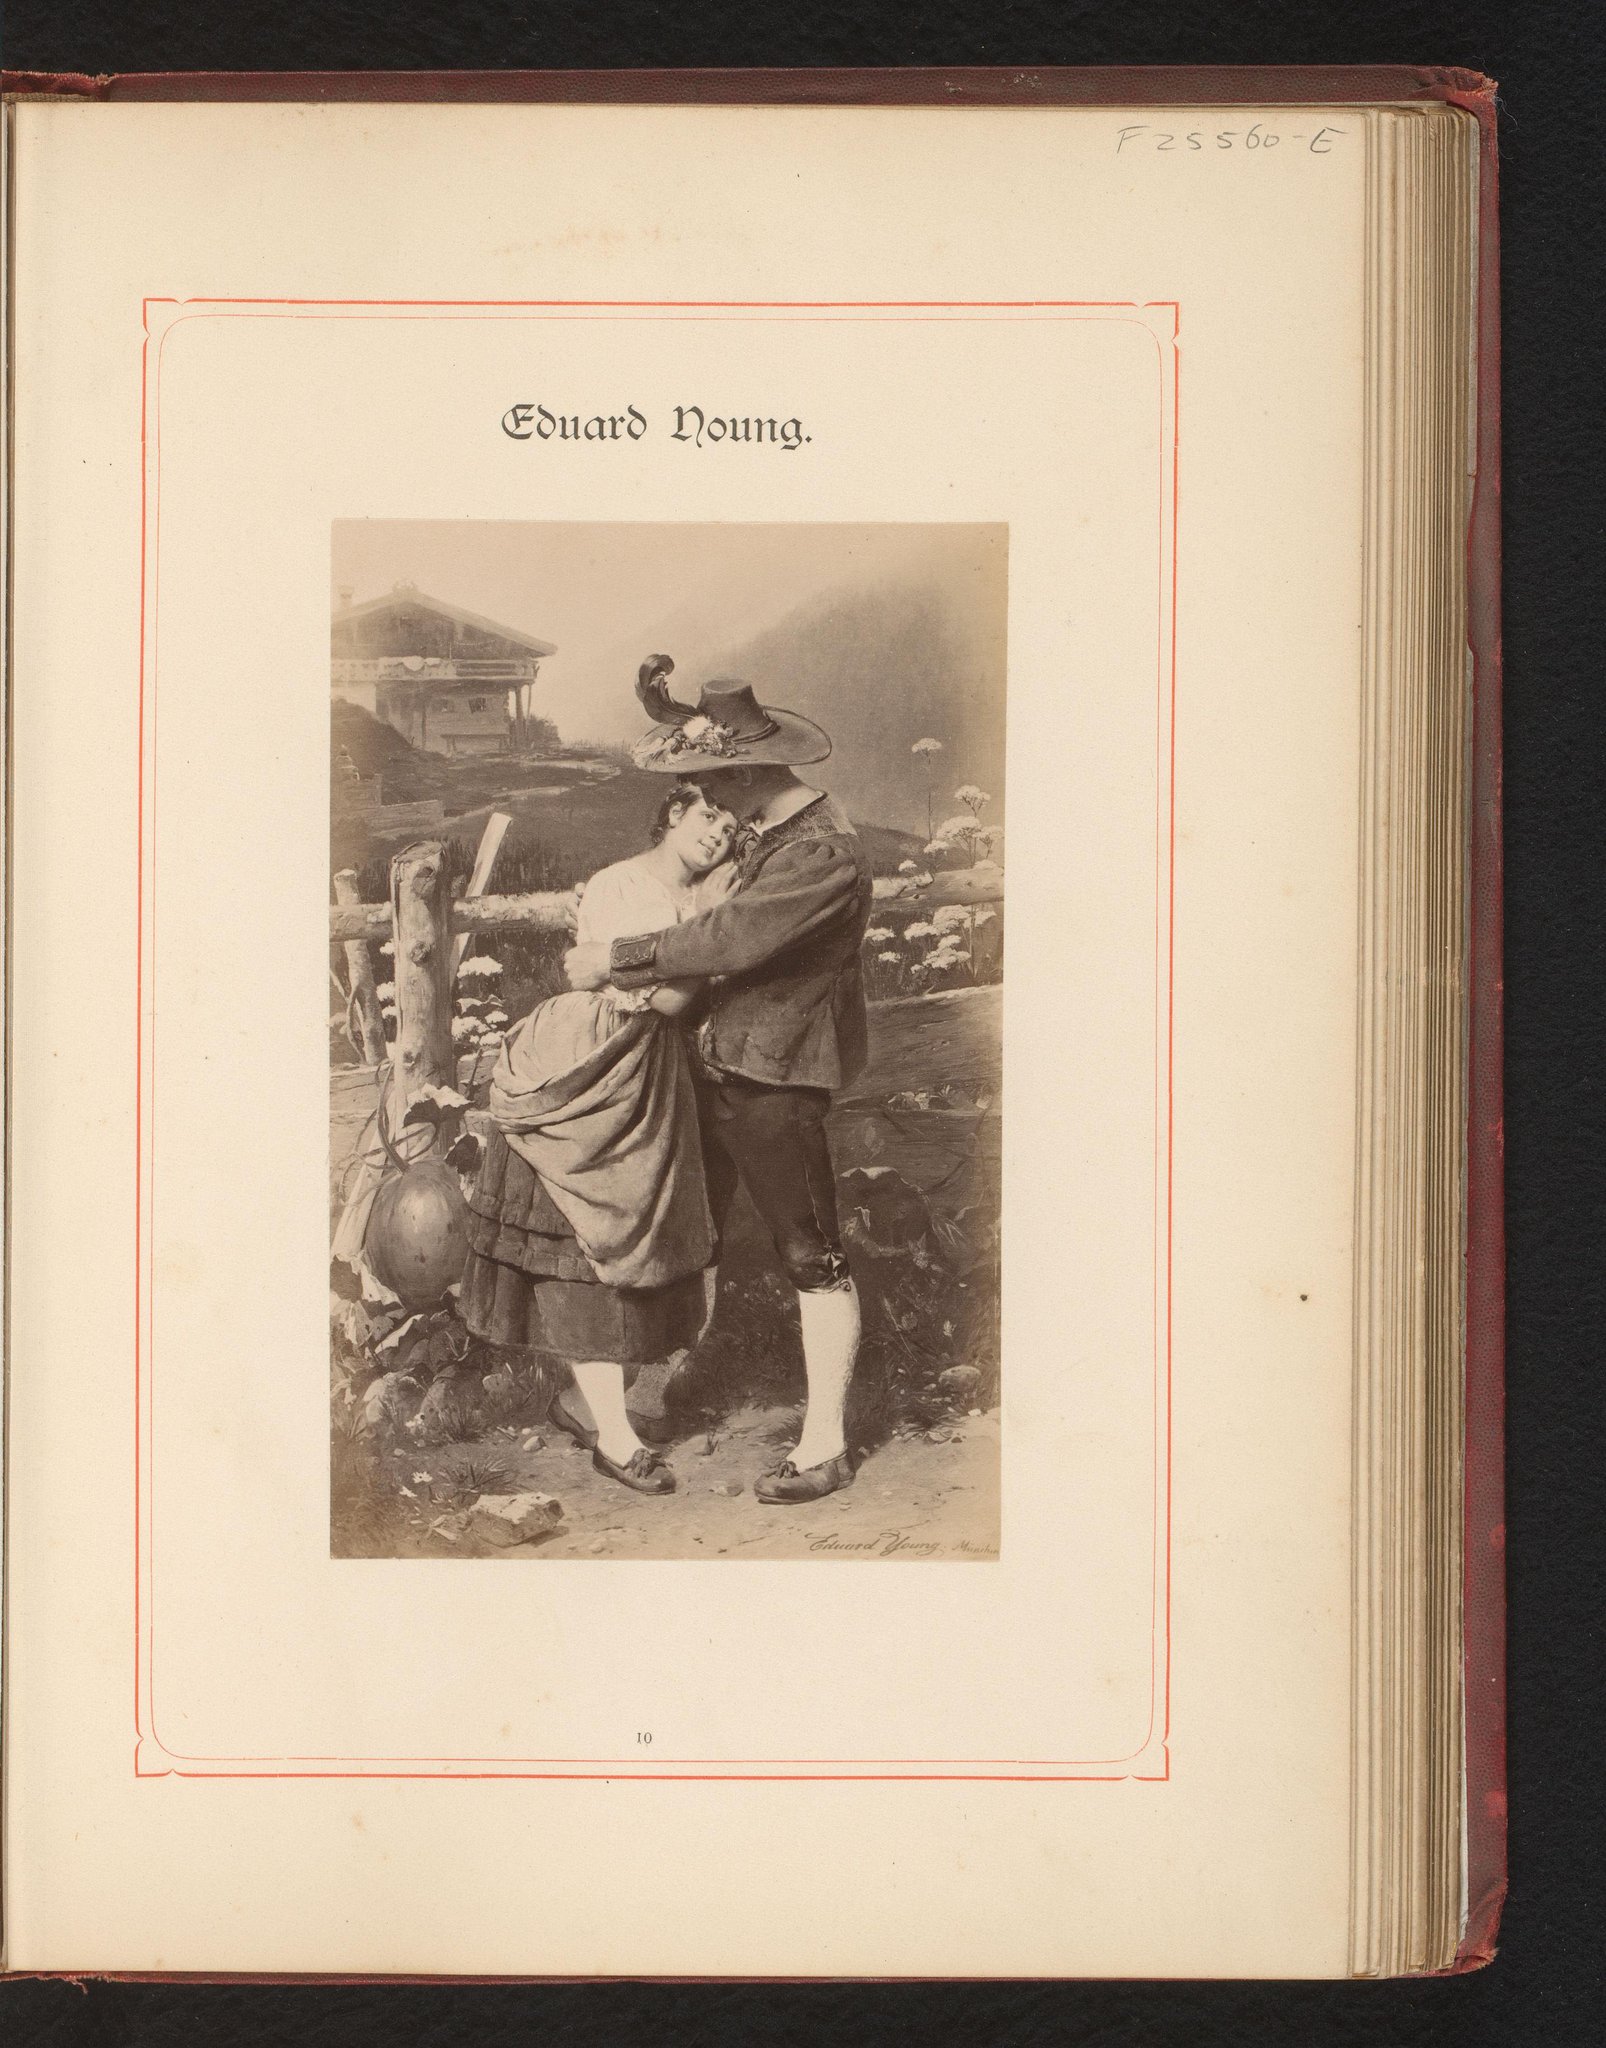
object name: photograph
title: Fotoreproductie van schilderij van een stel in Tiroler dracht door Edward Young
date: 1870-1890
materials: paper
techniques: albumen print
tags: folk costume, regional costume, picture, painting